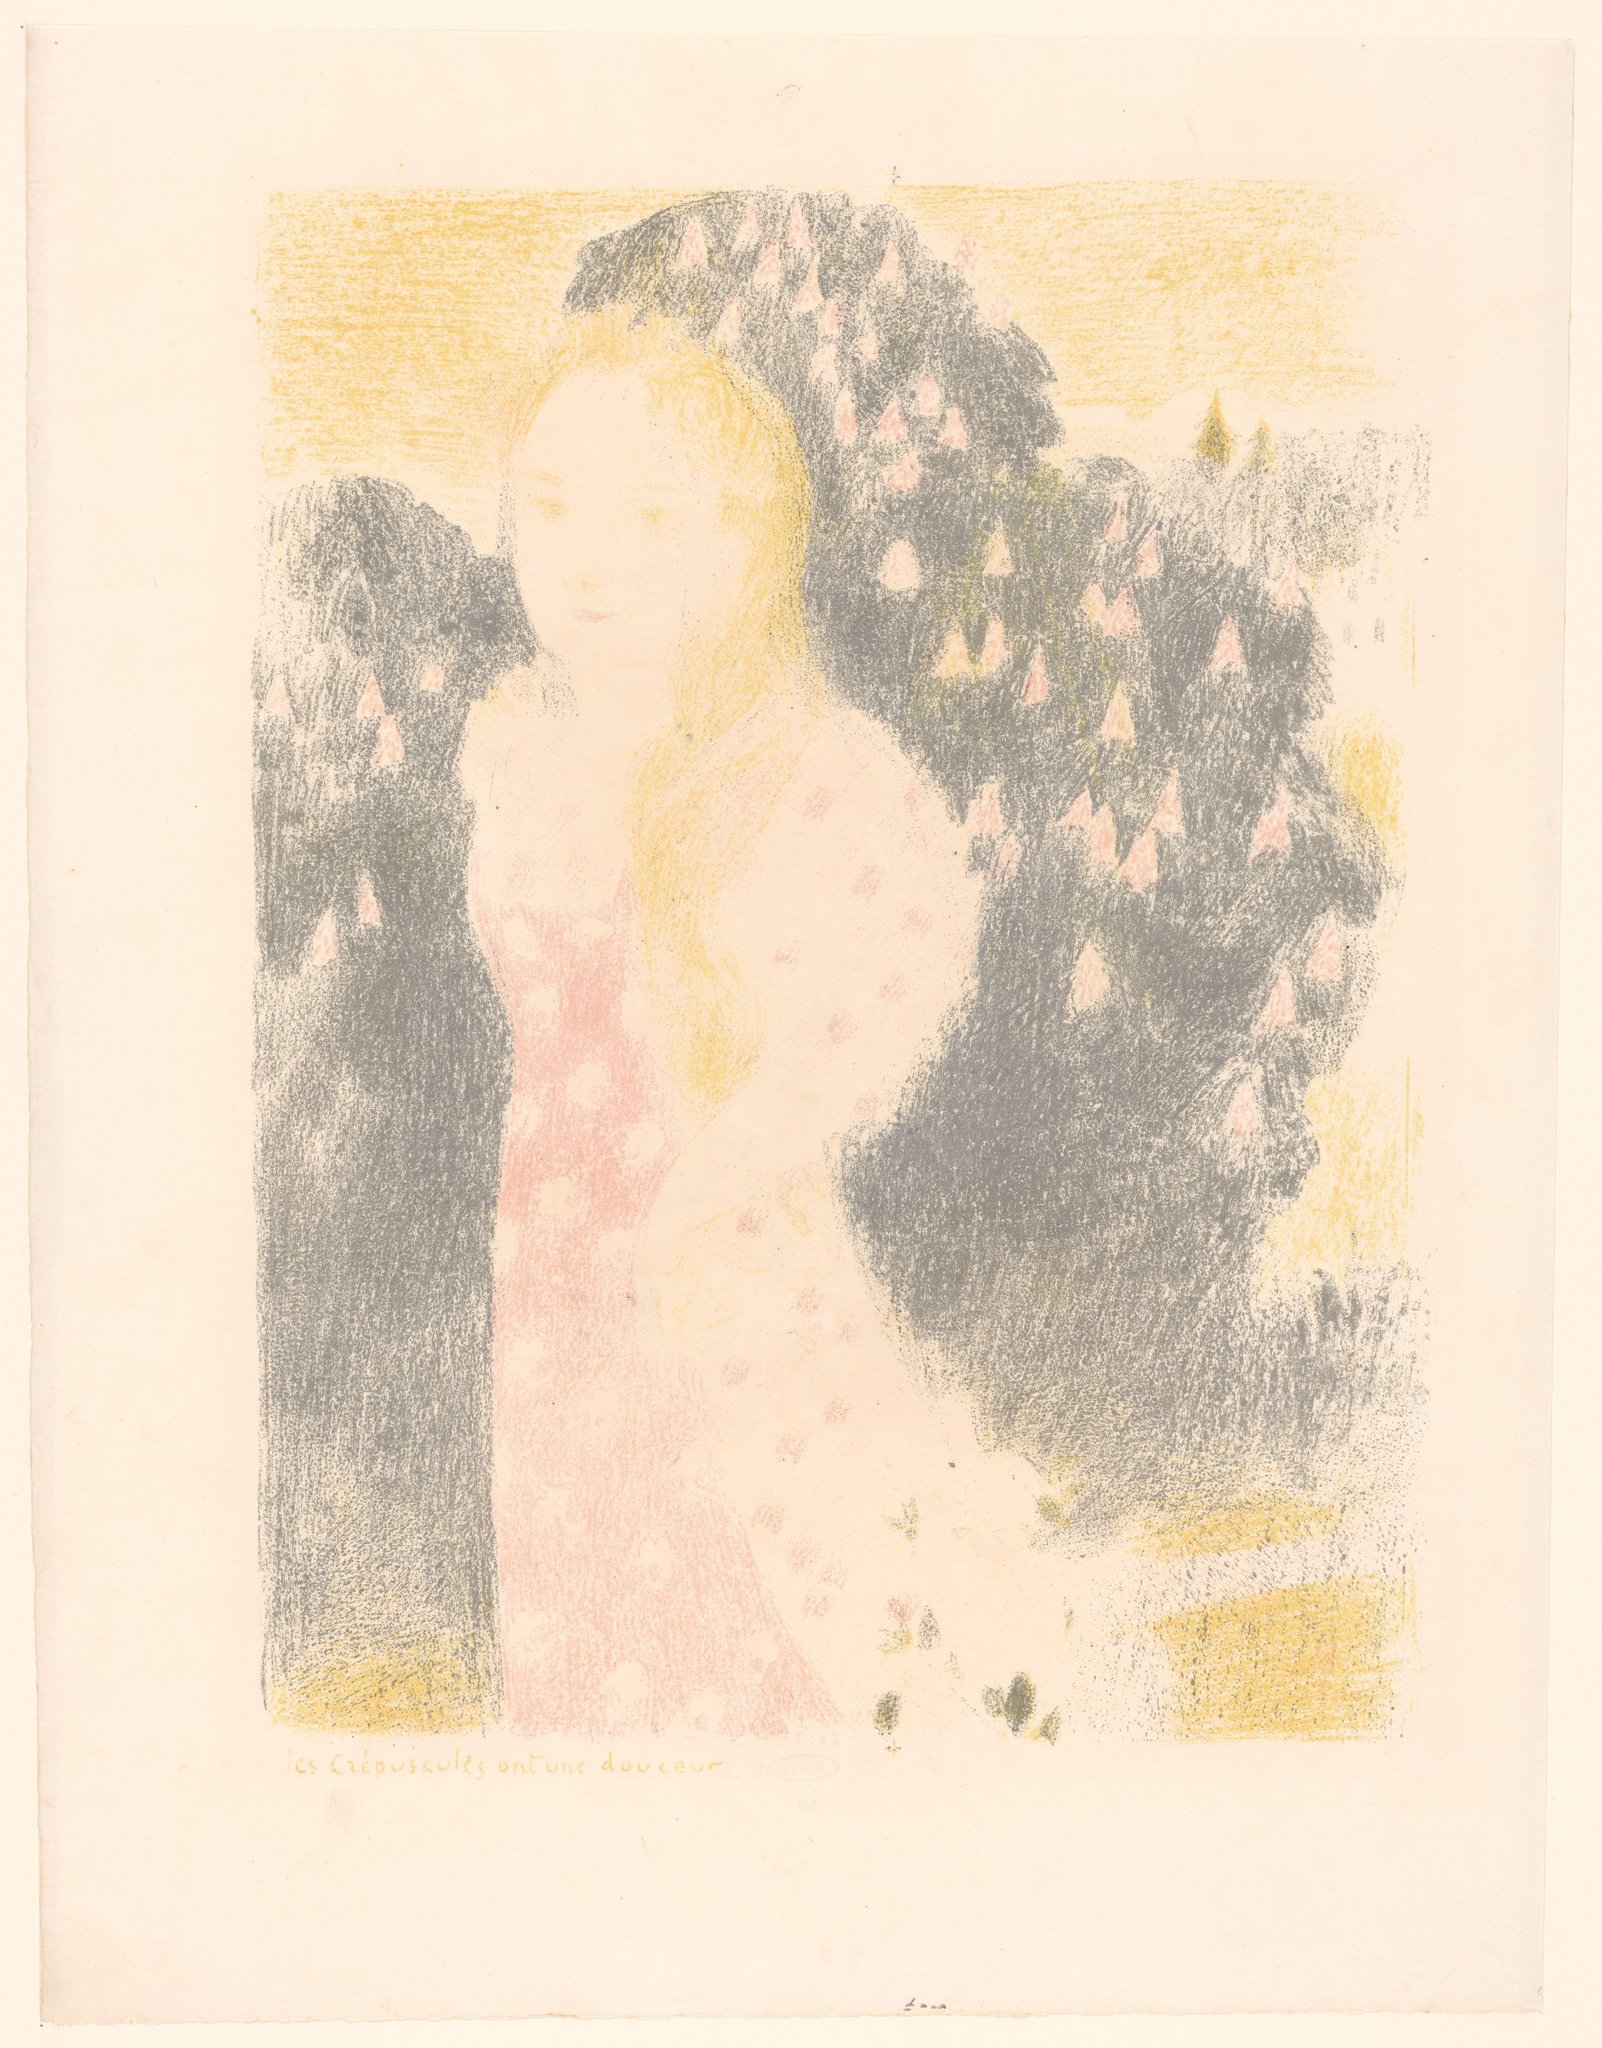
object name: print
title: Les crépuscules ont une douceur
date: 1898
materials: paper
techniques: lithograph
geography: paris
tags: flowers, adolescent, young woman, maiden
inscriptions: collector's mark: Lugt 2228a, collector's mark: Lugt 2760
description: Dit is de zesde prent uit een serie van twaalf.